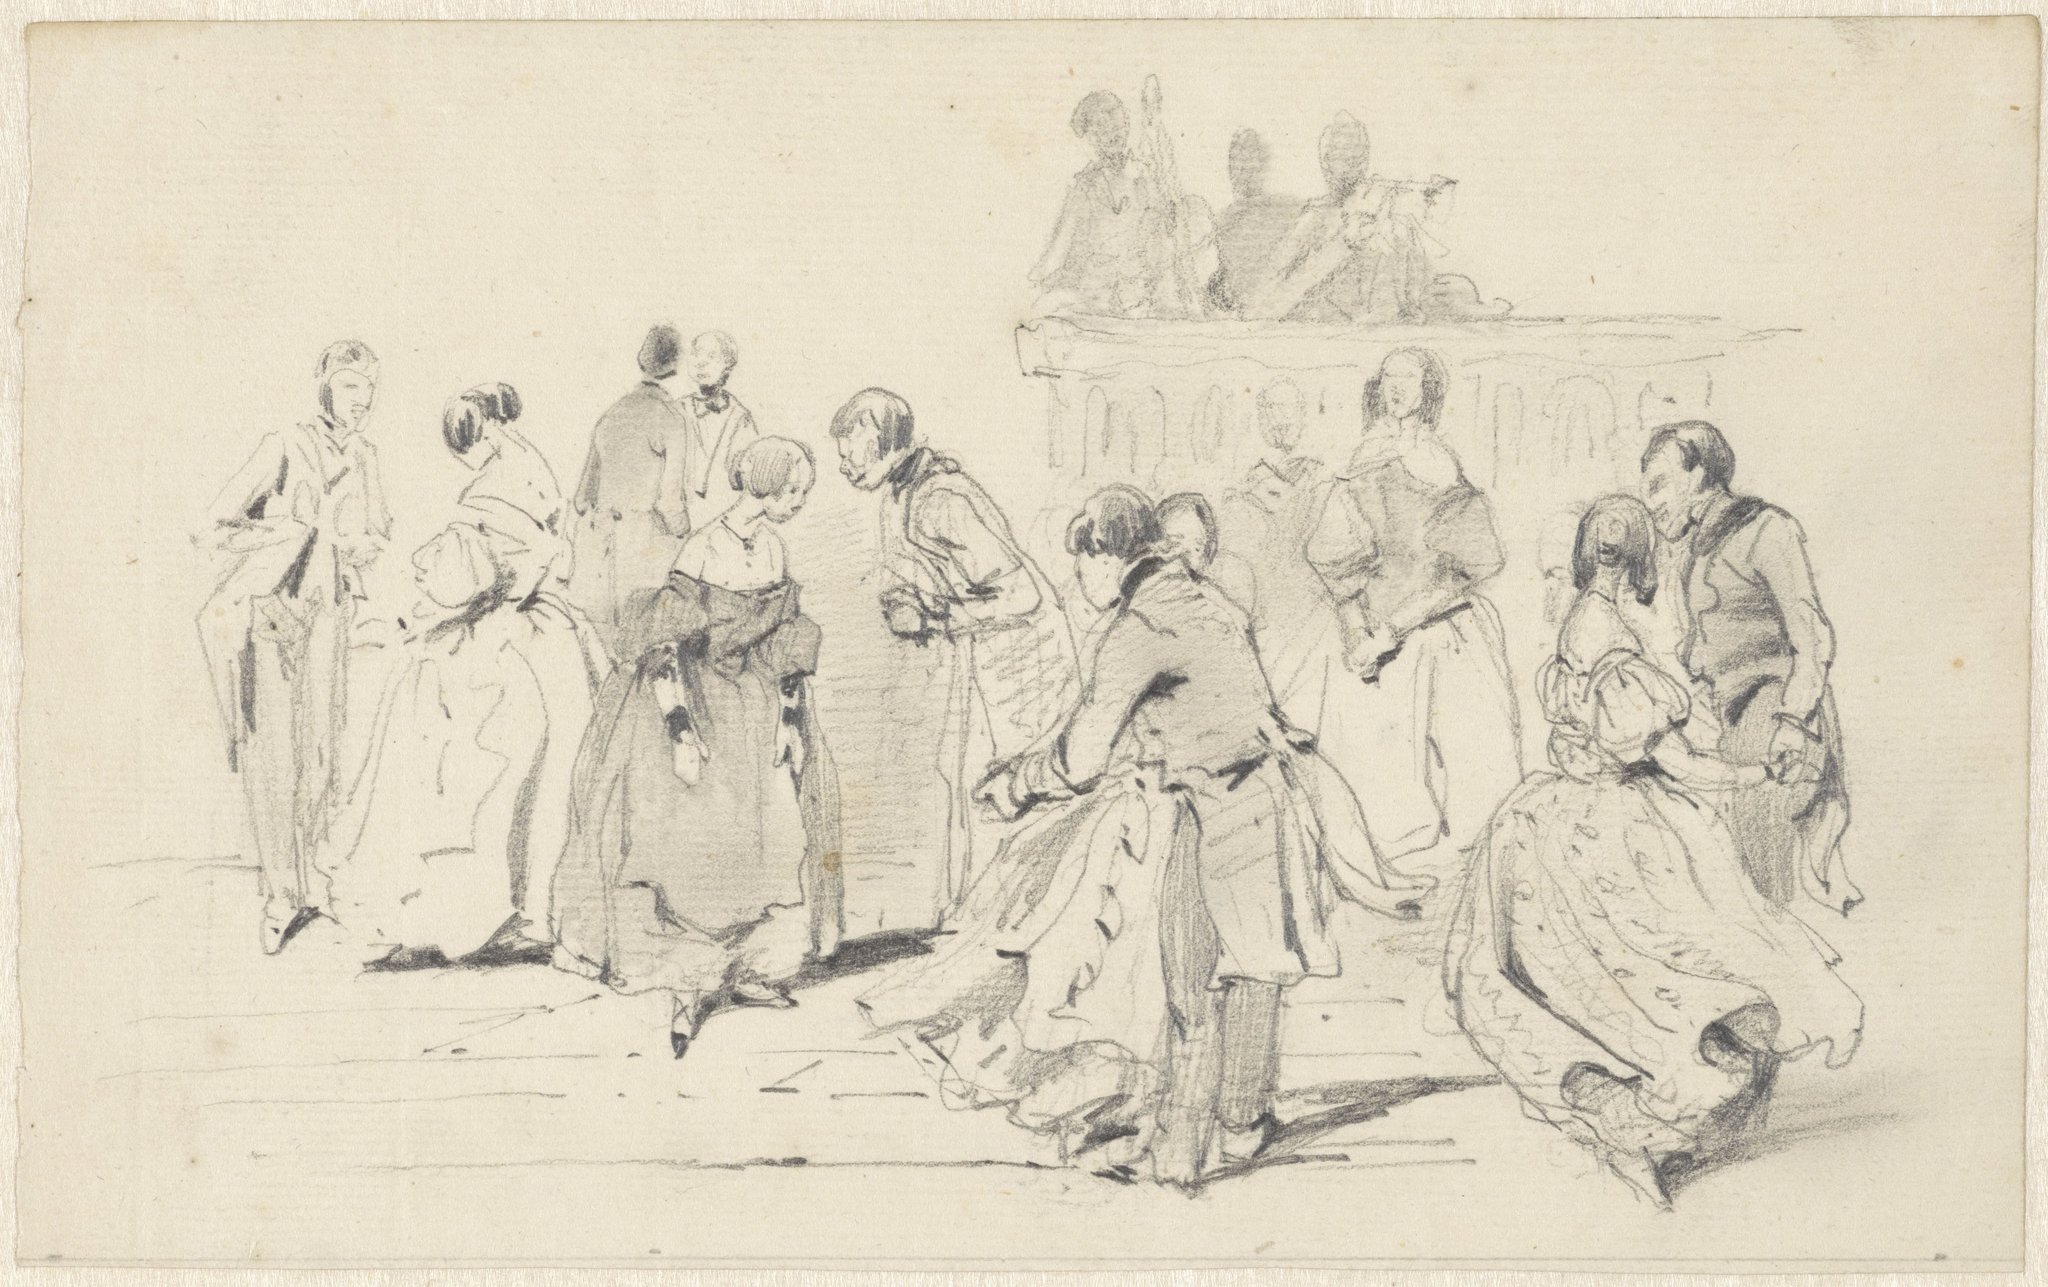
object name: drawing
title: Bal, op de achtergrond een orkestje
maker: pieter van loon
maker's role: draughtsman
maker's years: 1801-1873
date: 1811-1873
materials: paper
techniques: brush